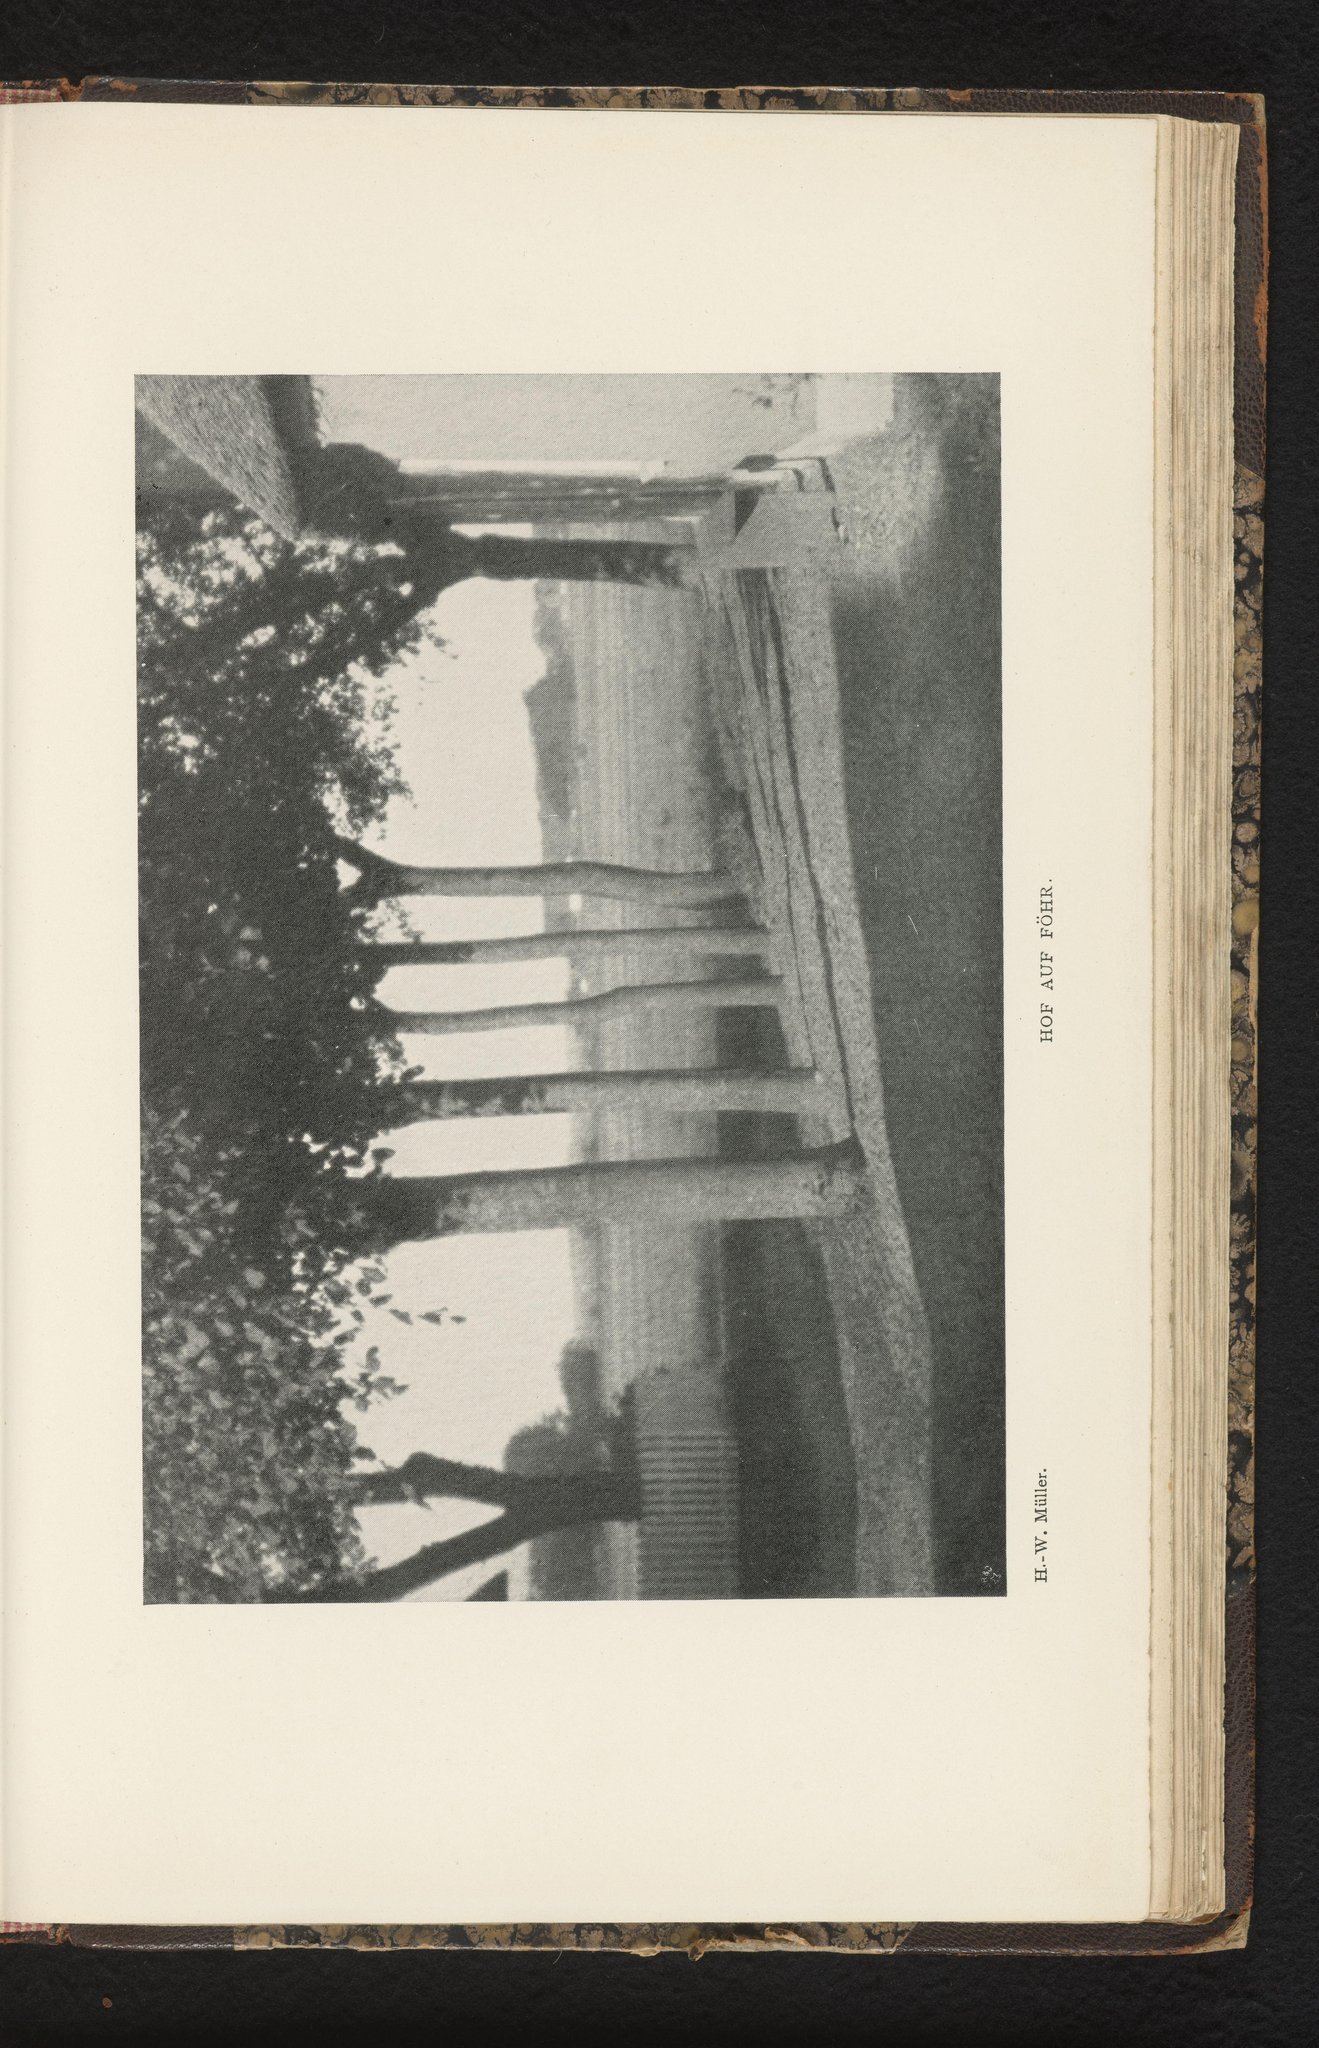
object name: photomechanical print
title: Gezicht op een rij bomen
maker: h.-w. müller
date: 1897-1902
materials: paper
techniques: autotype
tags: trees